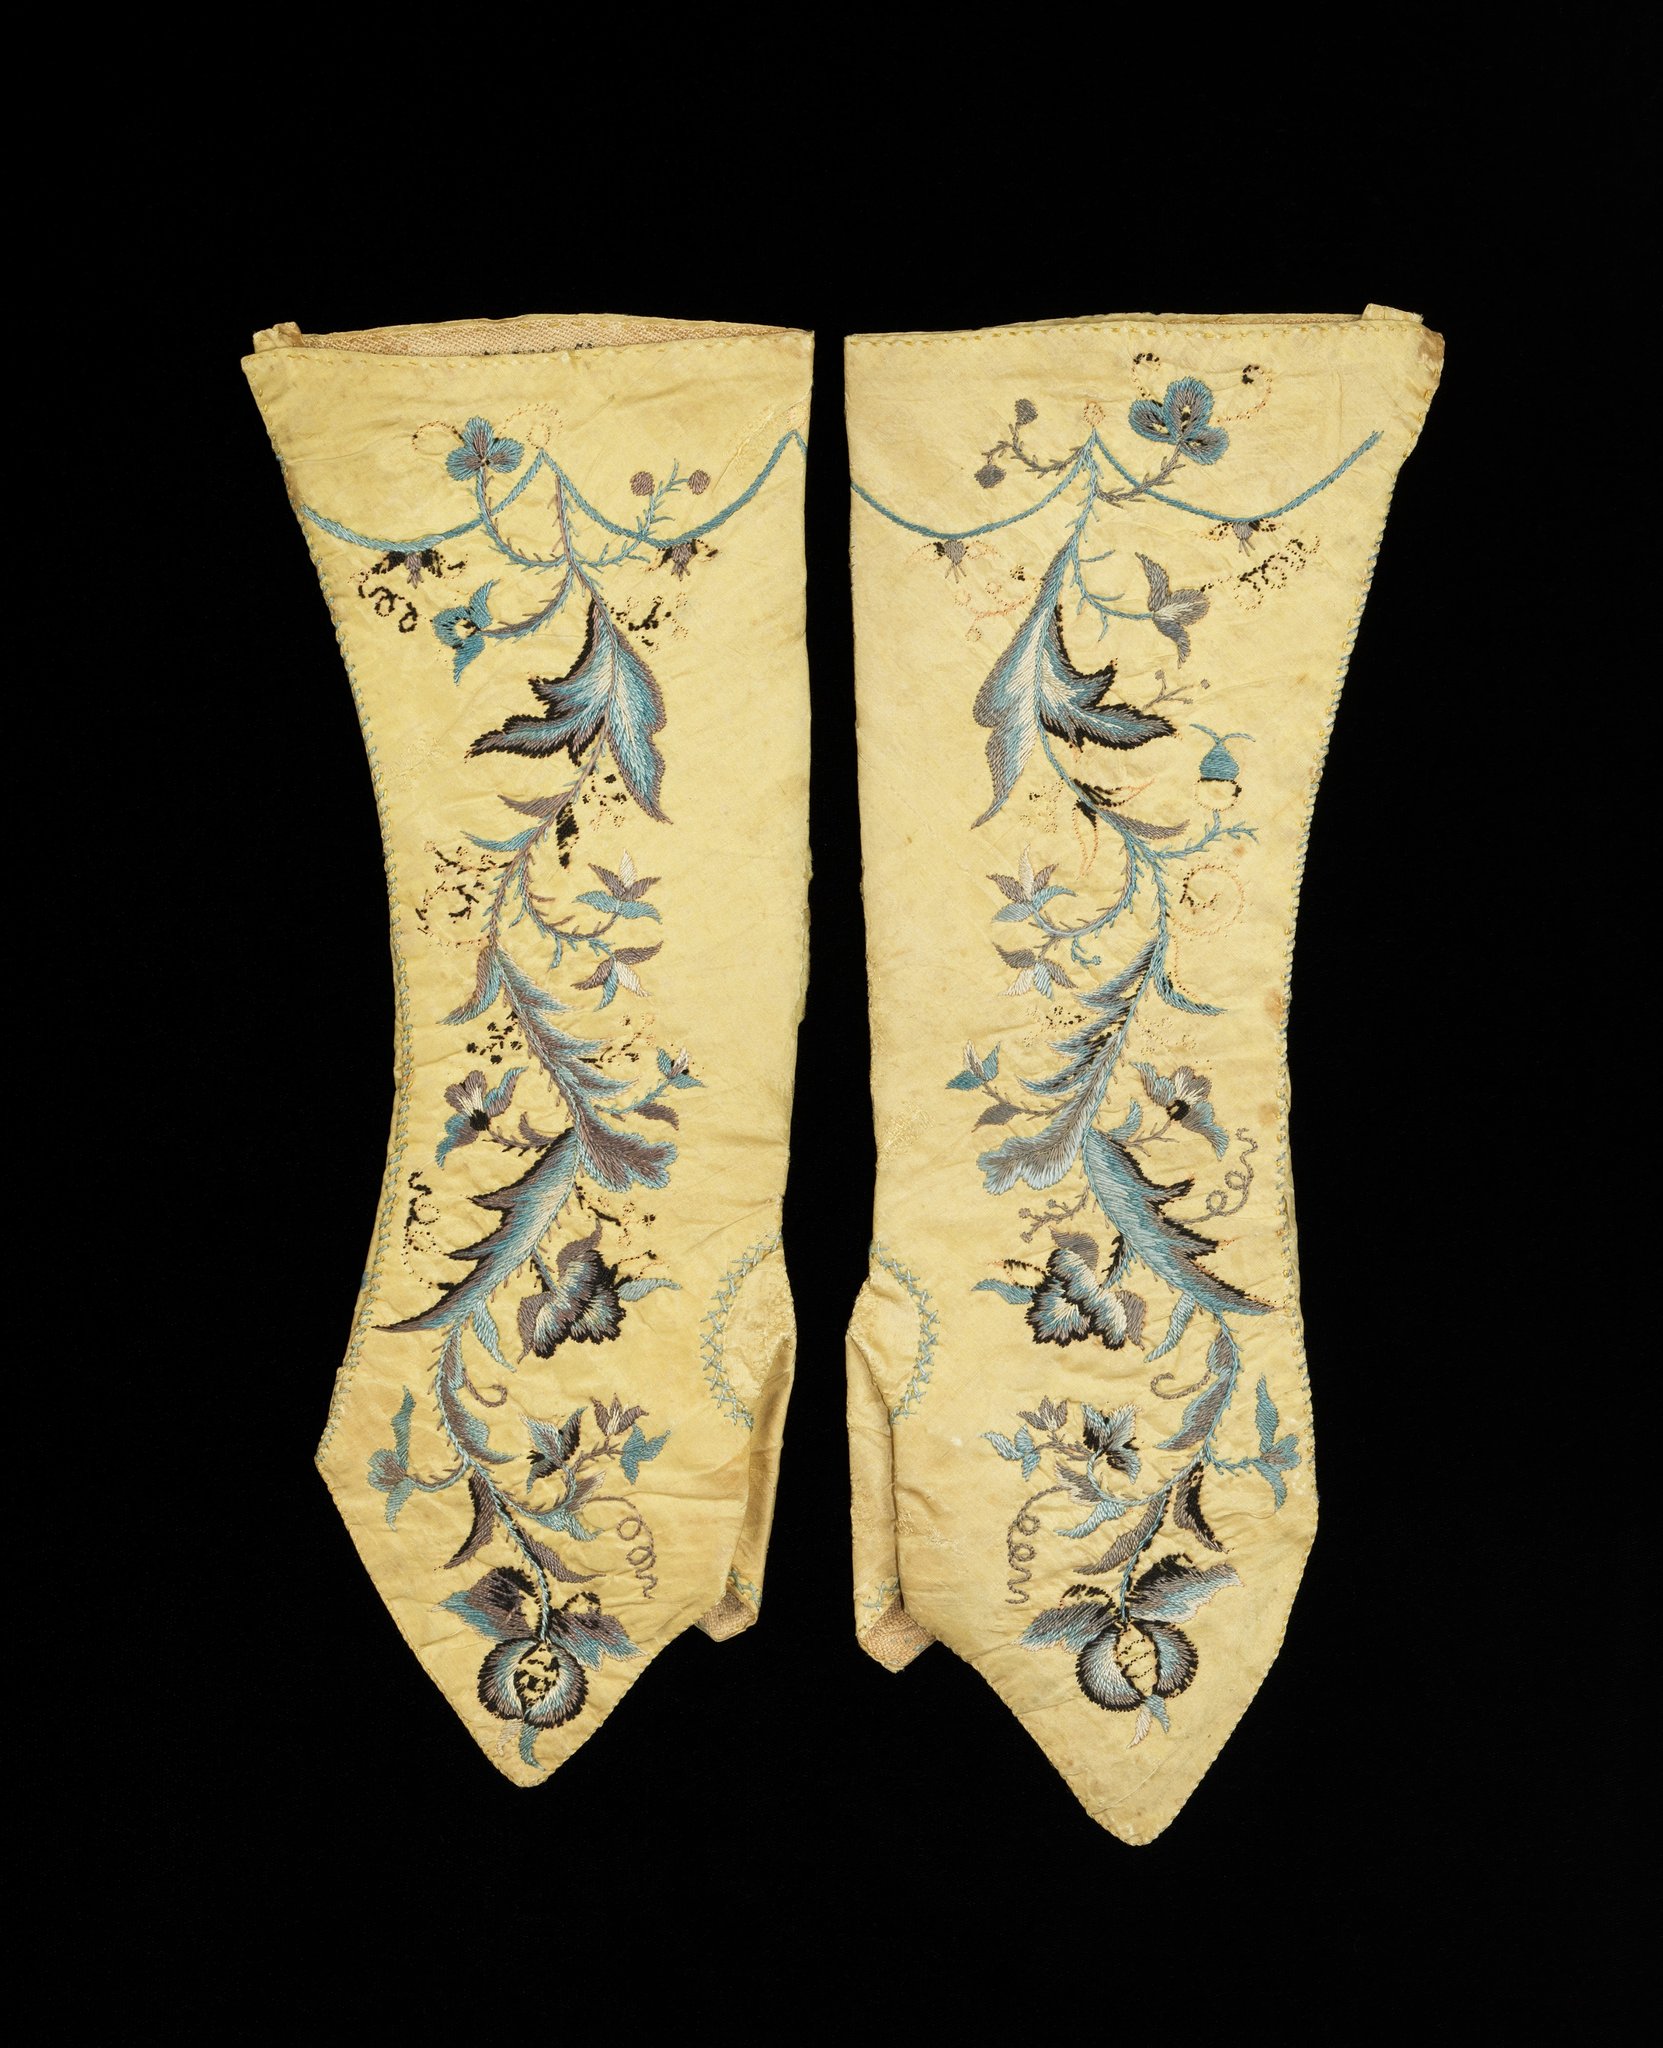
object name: mitt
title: Mitts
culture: british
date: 1701-1725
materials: silk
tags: flowers